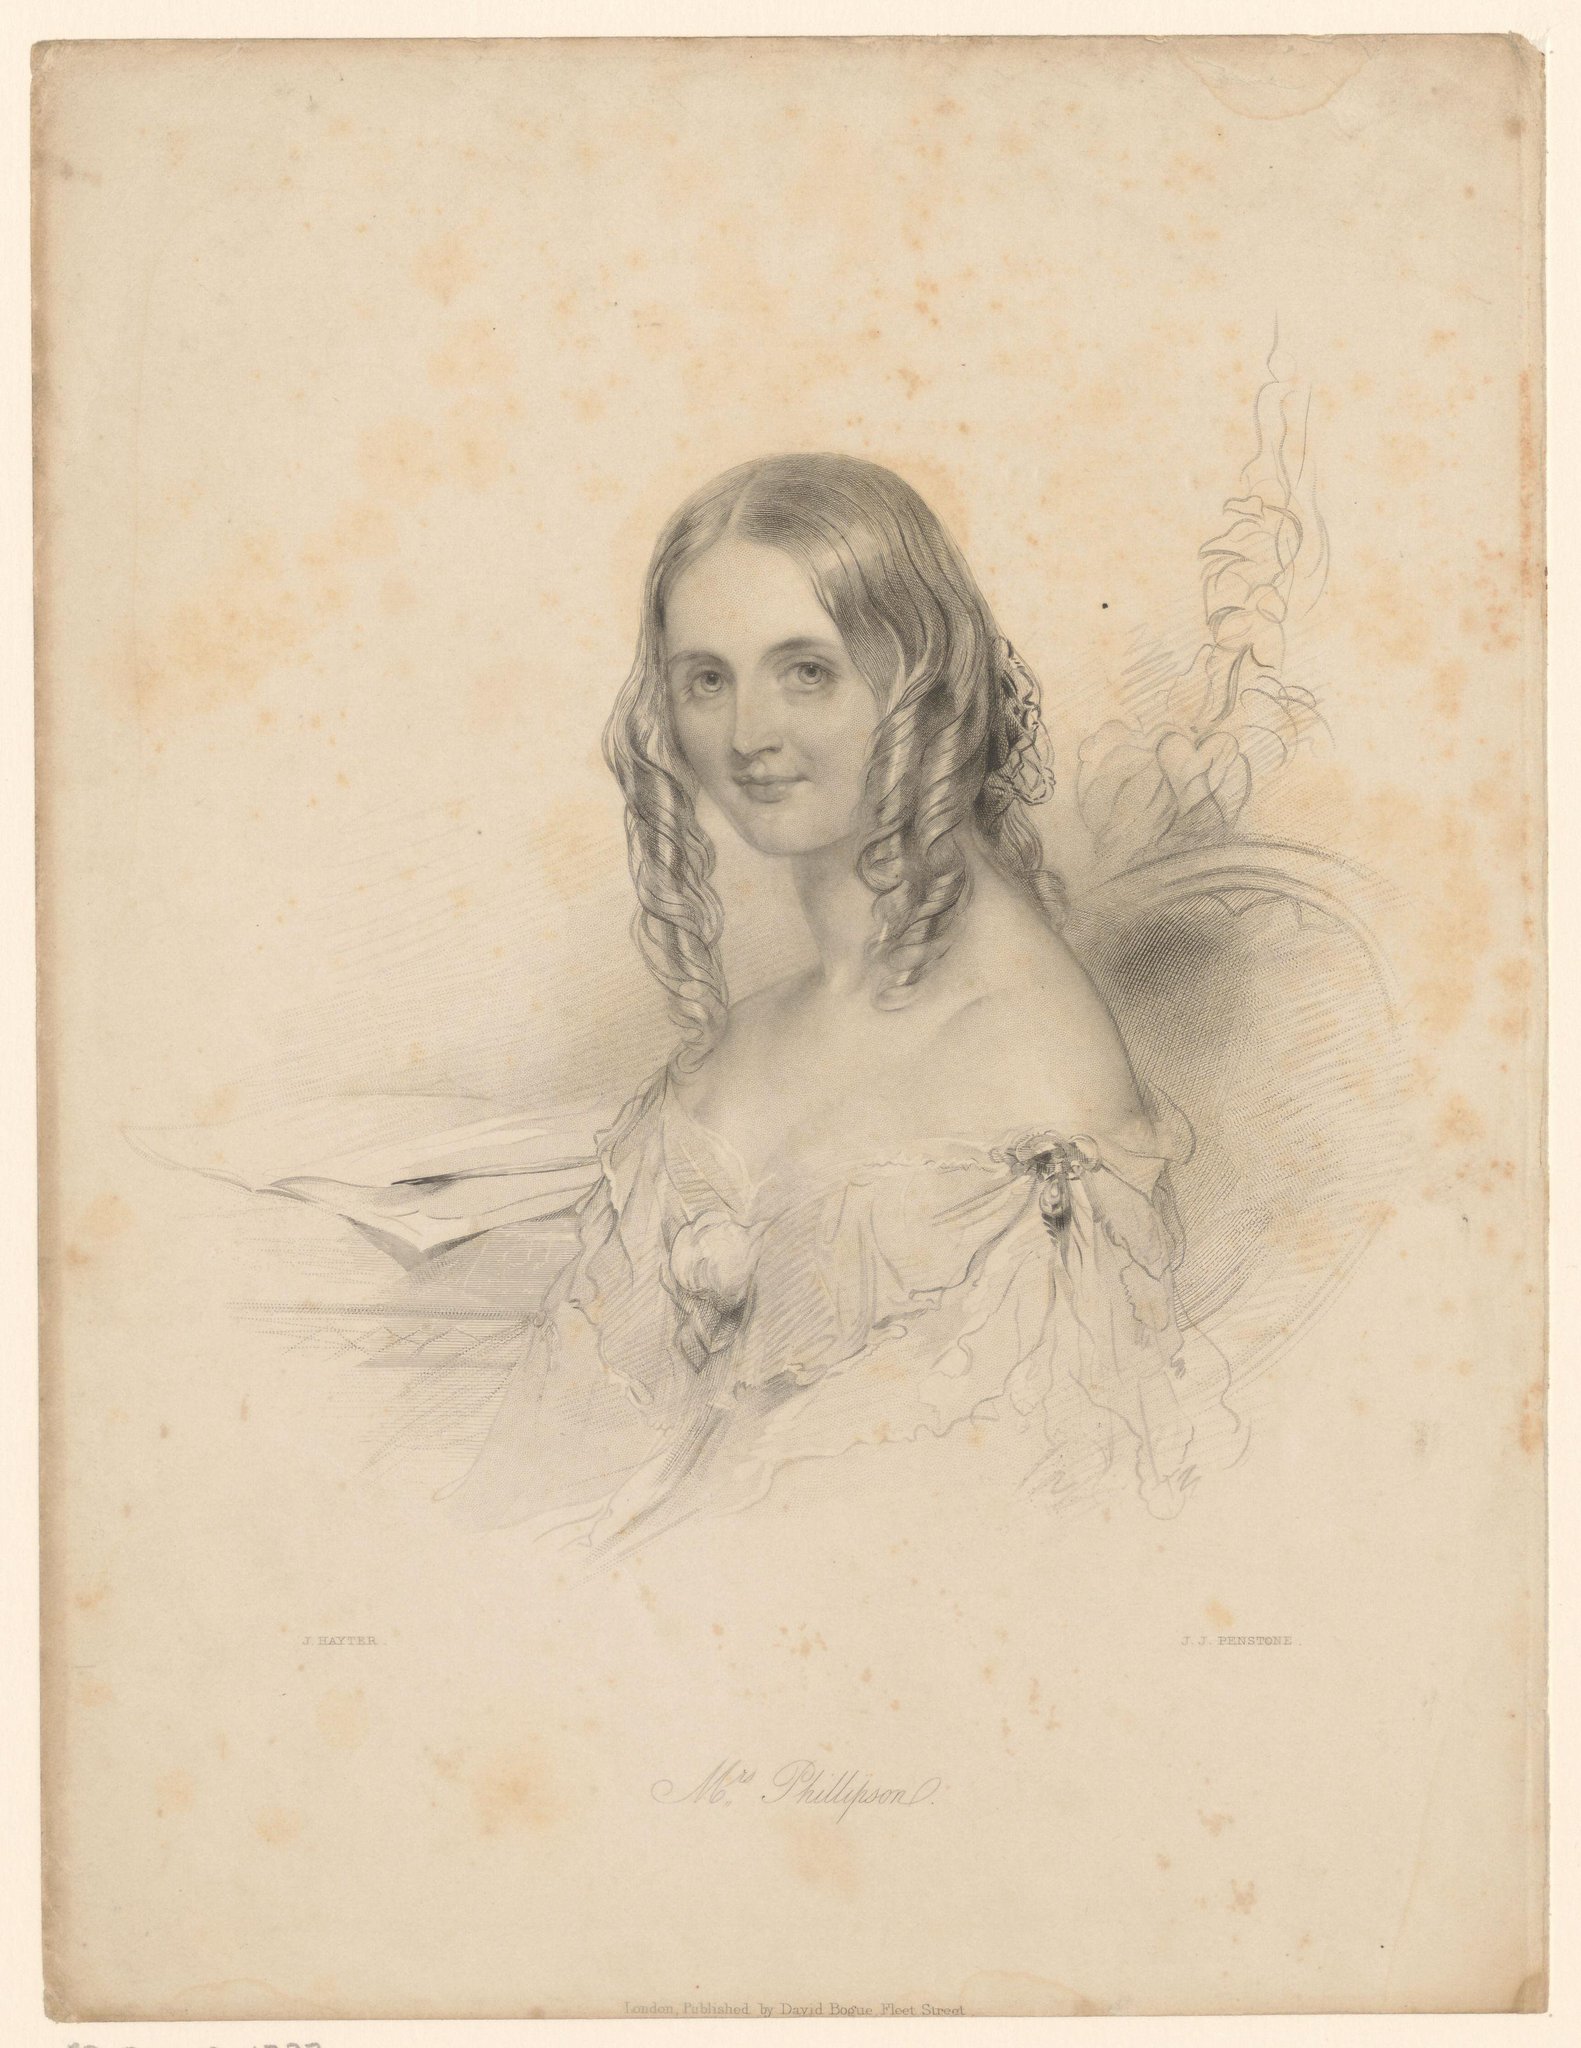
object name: print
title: Portret van mevrouw Phillipson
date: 1852-1856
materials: paper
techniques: etching, roulette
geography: london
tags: anonymous historical person portrayed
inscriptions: collector's mark: Lugt 2228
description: Prent uit: The Court Album: A Series of Portraits of the Female Aristocracy. Londen: David Bogue, [ca. 1852-1856].